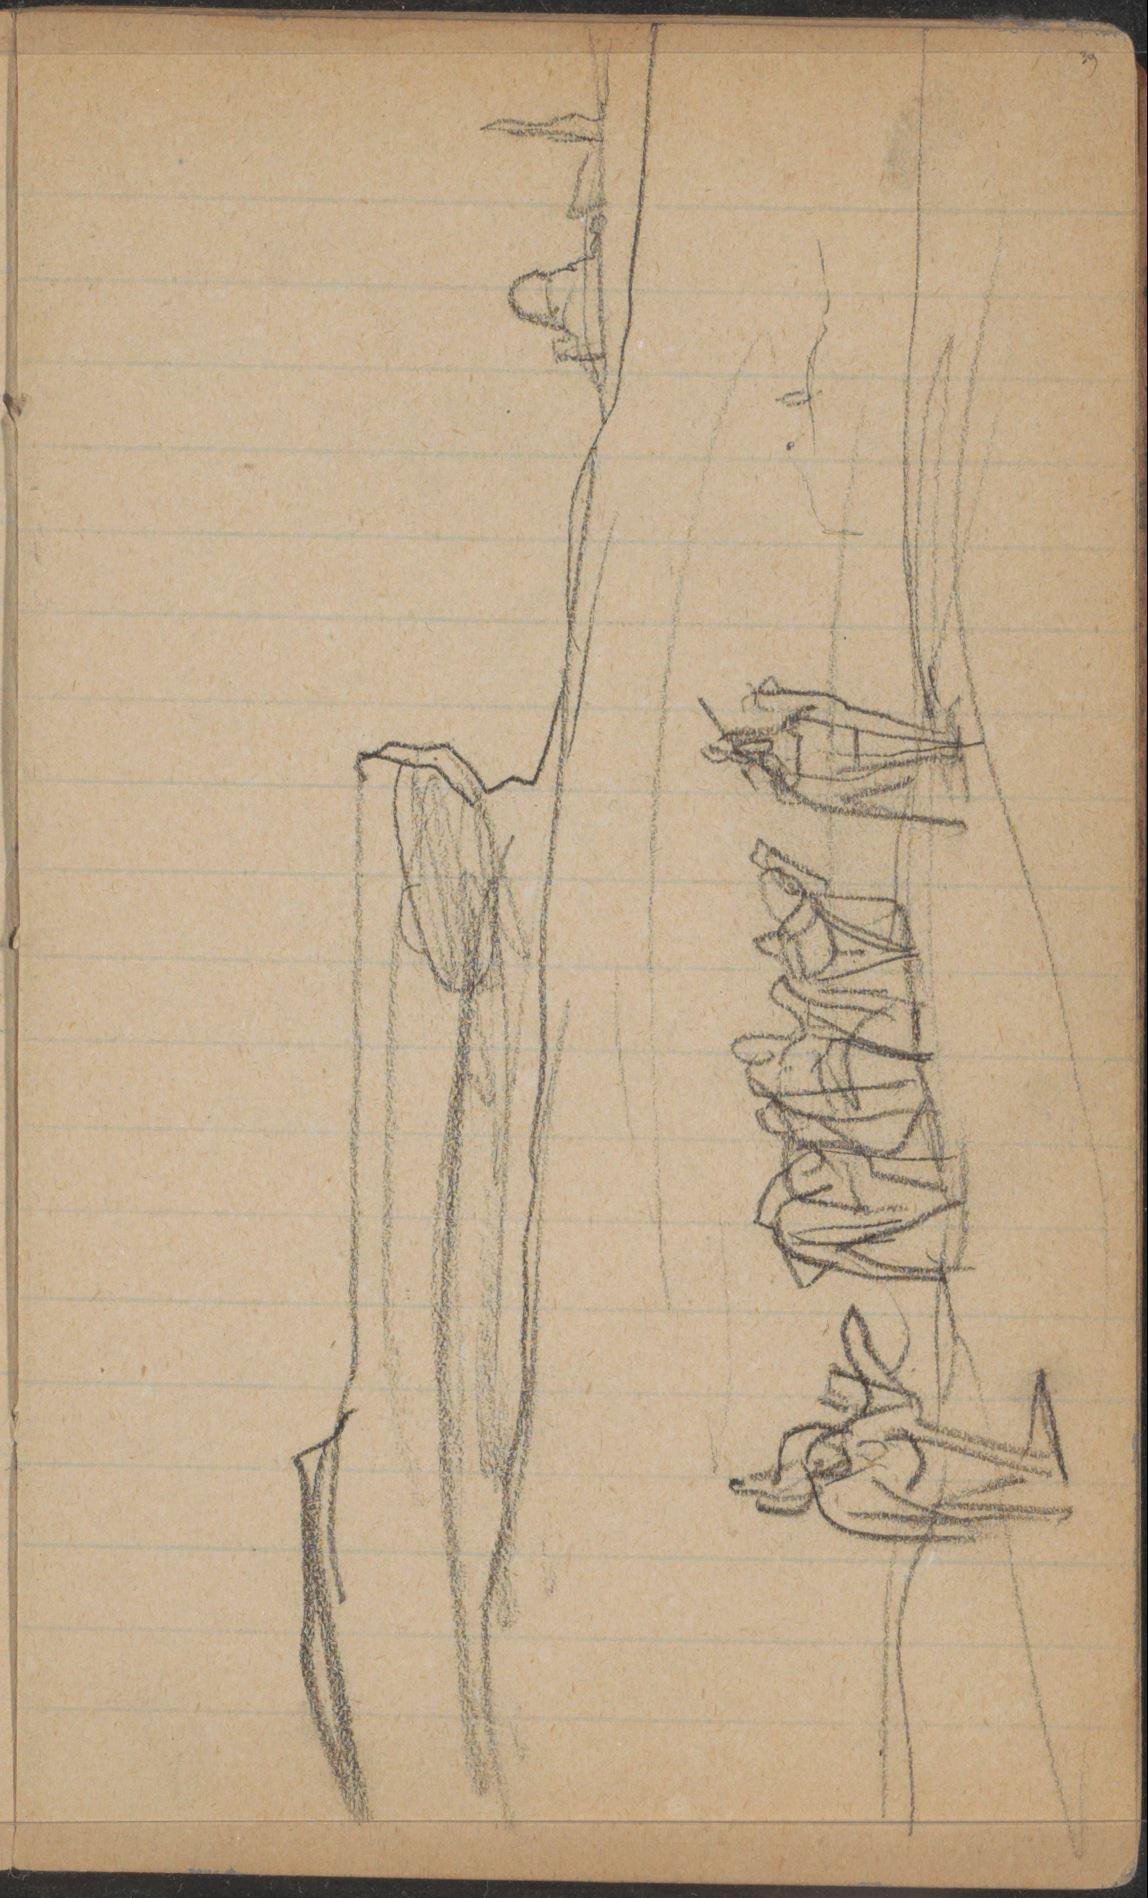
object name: sketchbook leaf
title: Woestijnlandschap met figuren op kamelen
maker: marius bauer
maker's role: draughtsman, print maker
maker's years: 1867-1932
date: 1894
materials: chalk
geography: cairo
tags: hoofed animals: camel, city-view, and landscape with man-made constructions, sitting figure, desert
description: Op de achtergrond mogelijk het Mausoleum van Yunus al-Dawadar. Pagina 39 uit een schetsboek met 48 bladen.